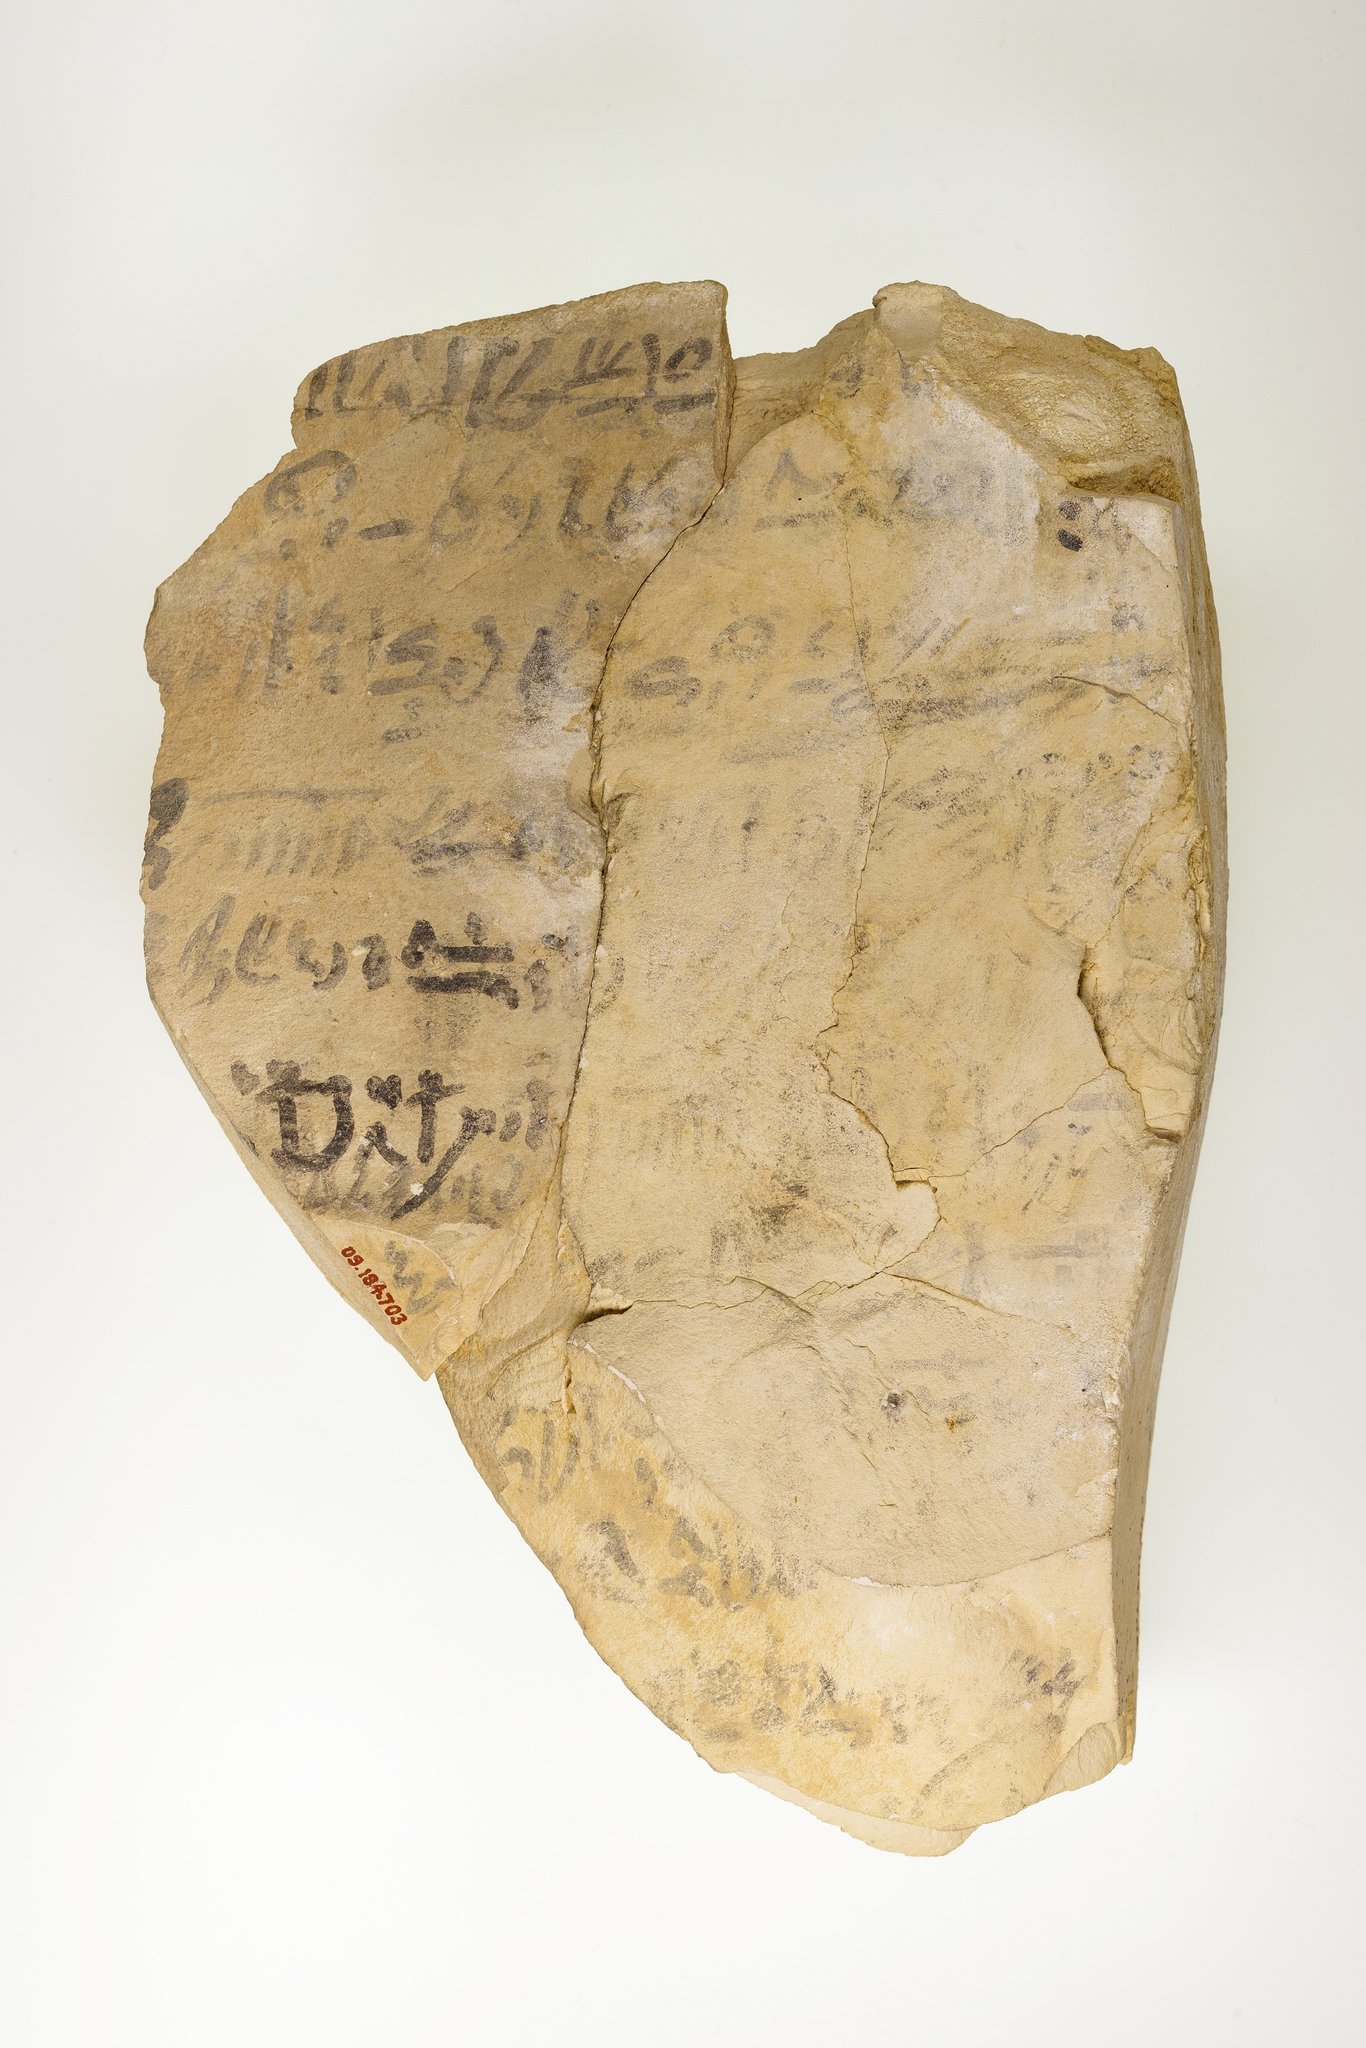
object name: ostracon, hieratic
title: Hieratic ostracon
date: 1186-1070 BCE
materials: ink, limestone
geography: egypt